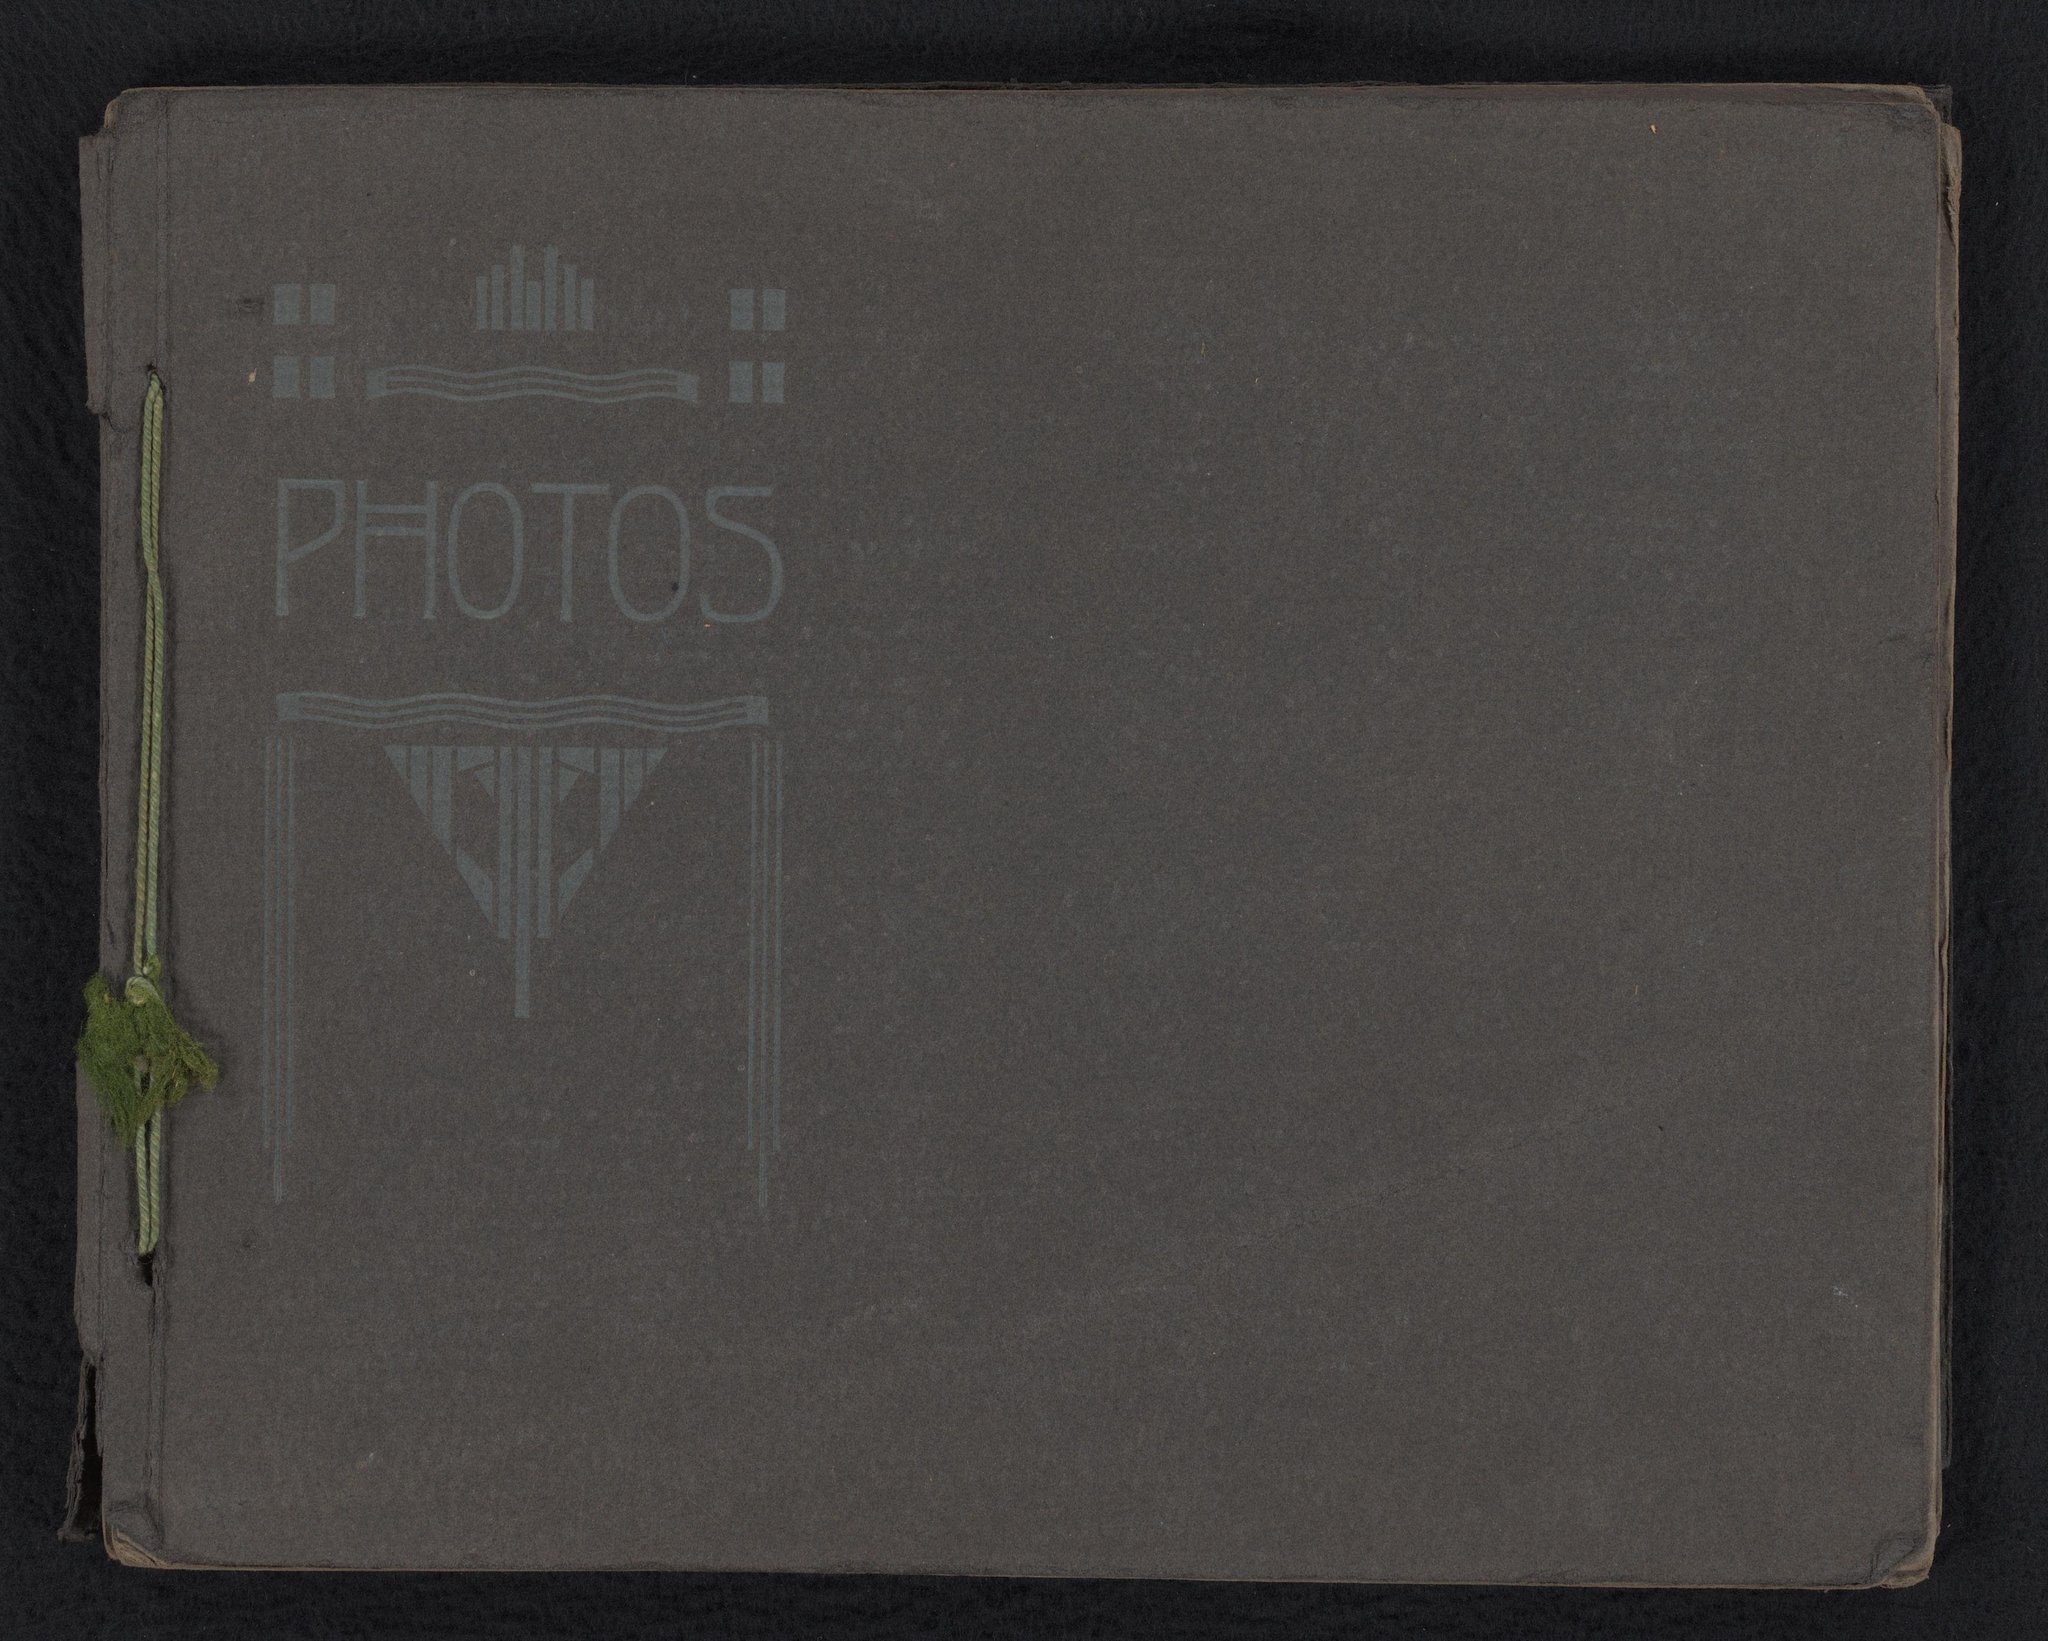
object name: photograph album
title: Fotoalbum met foto's van Arthur Moos tijdens zijn militaire diensttijd bij het Duitse Regiment Ulanen (1905-1906)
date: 1905-1906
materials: cardboard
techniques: gelatin silver print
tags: arthur moos, germany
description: Dit object is onderdeel van de nalatenschap van Isabel Elon-Wachenheimer (1928-2010). Tot haar overlijden behoorde het samen met de andere objecten uit de nalatenschap tot haar privédomein van Isabel Wachenheimer. In die particuliere context zijn deze objecten tezamen en individueel aandenkens - aan de jeugd, ouders en familie van Isabel Wachenheimer vóór en tijdens de Shoah en aan haar leven na de Tweede Wereldoorlog. Isabel Wachenheimer, die van juni 1943 tot mei 1945 gevangen zat in Kamp Westerbork, Theresienstadt, Auschwitz, Lenzing a/d Oberdonau (een buitenkamp van Mauthausen), overleefde de Shoah. Haar ouders – Eugène Wachenheimer en Else Wachenheimer-Moos - werden op 14 oktober 1944 in Auschwitz-Birkenau vermoord.